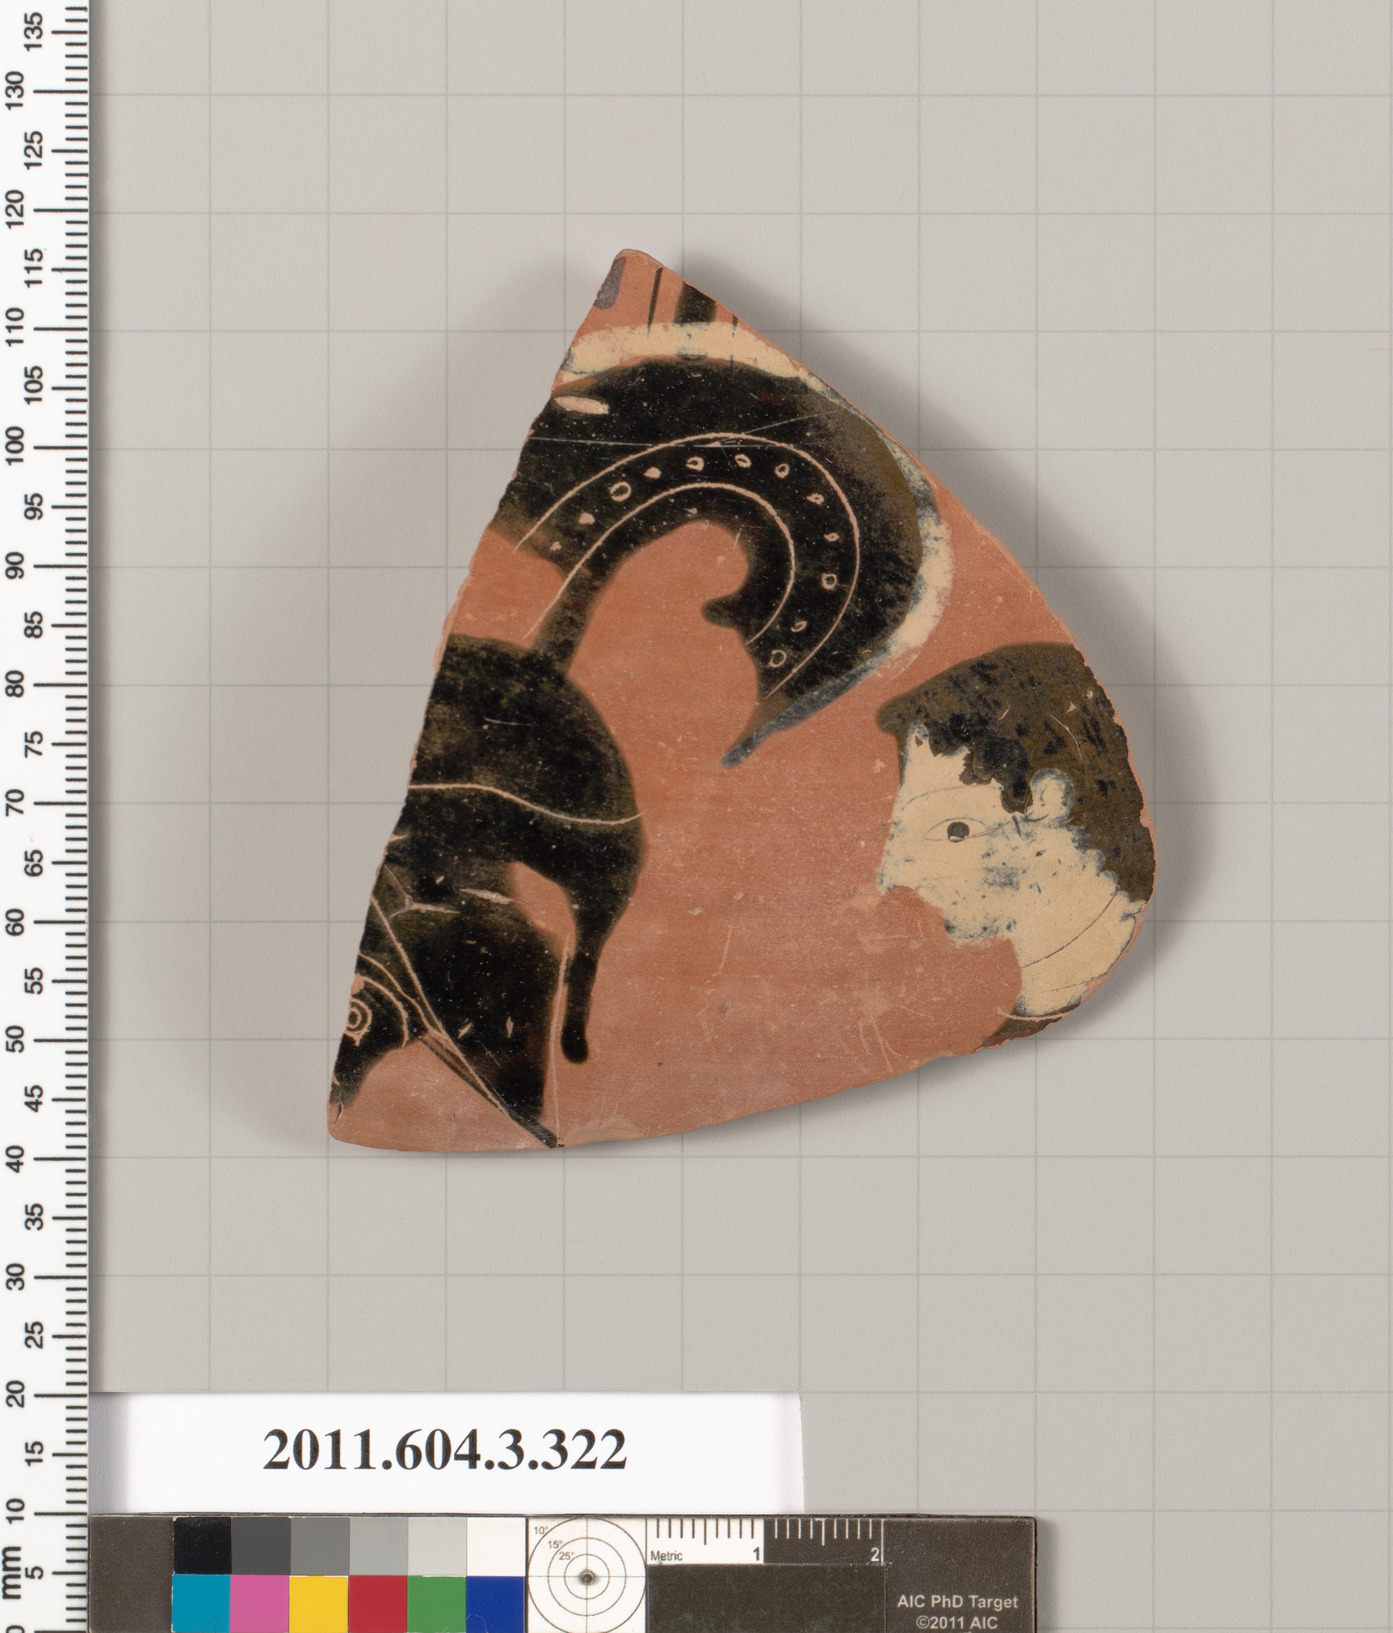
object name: neck amphora fragment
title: Terracotta fragment of a neck-amphora (jar)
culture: greek, attic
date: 550-526 BCE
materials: terracotta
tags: helmets